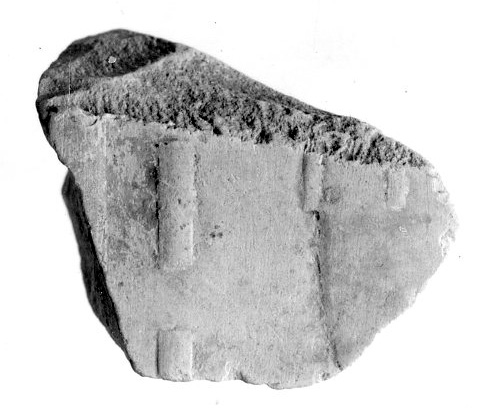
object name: relief fragment, tomb of meketre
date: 1981-1975 BCE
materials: limestone, paint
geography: egypt